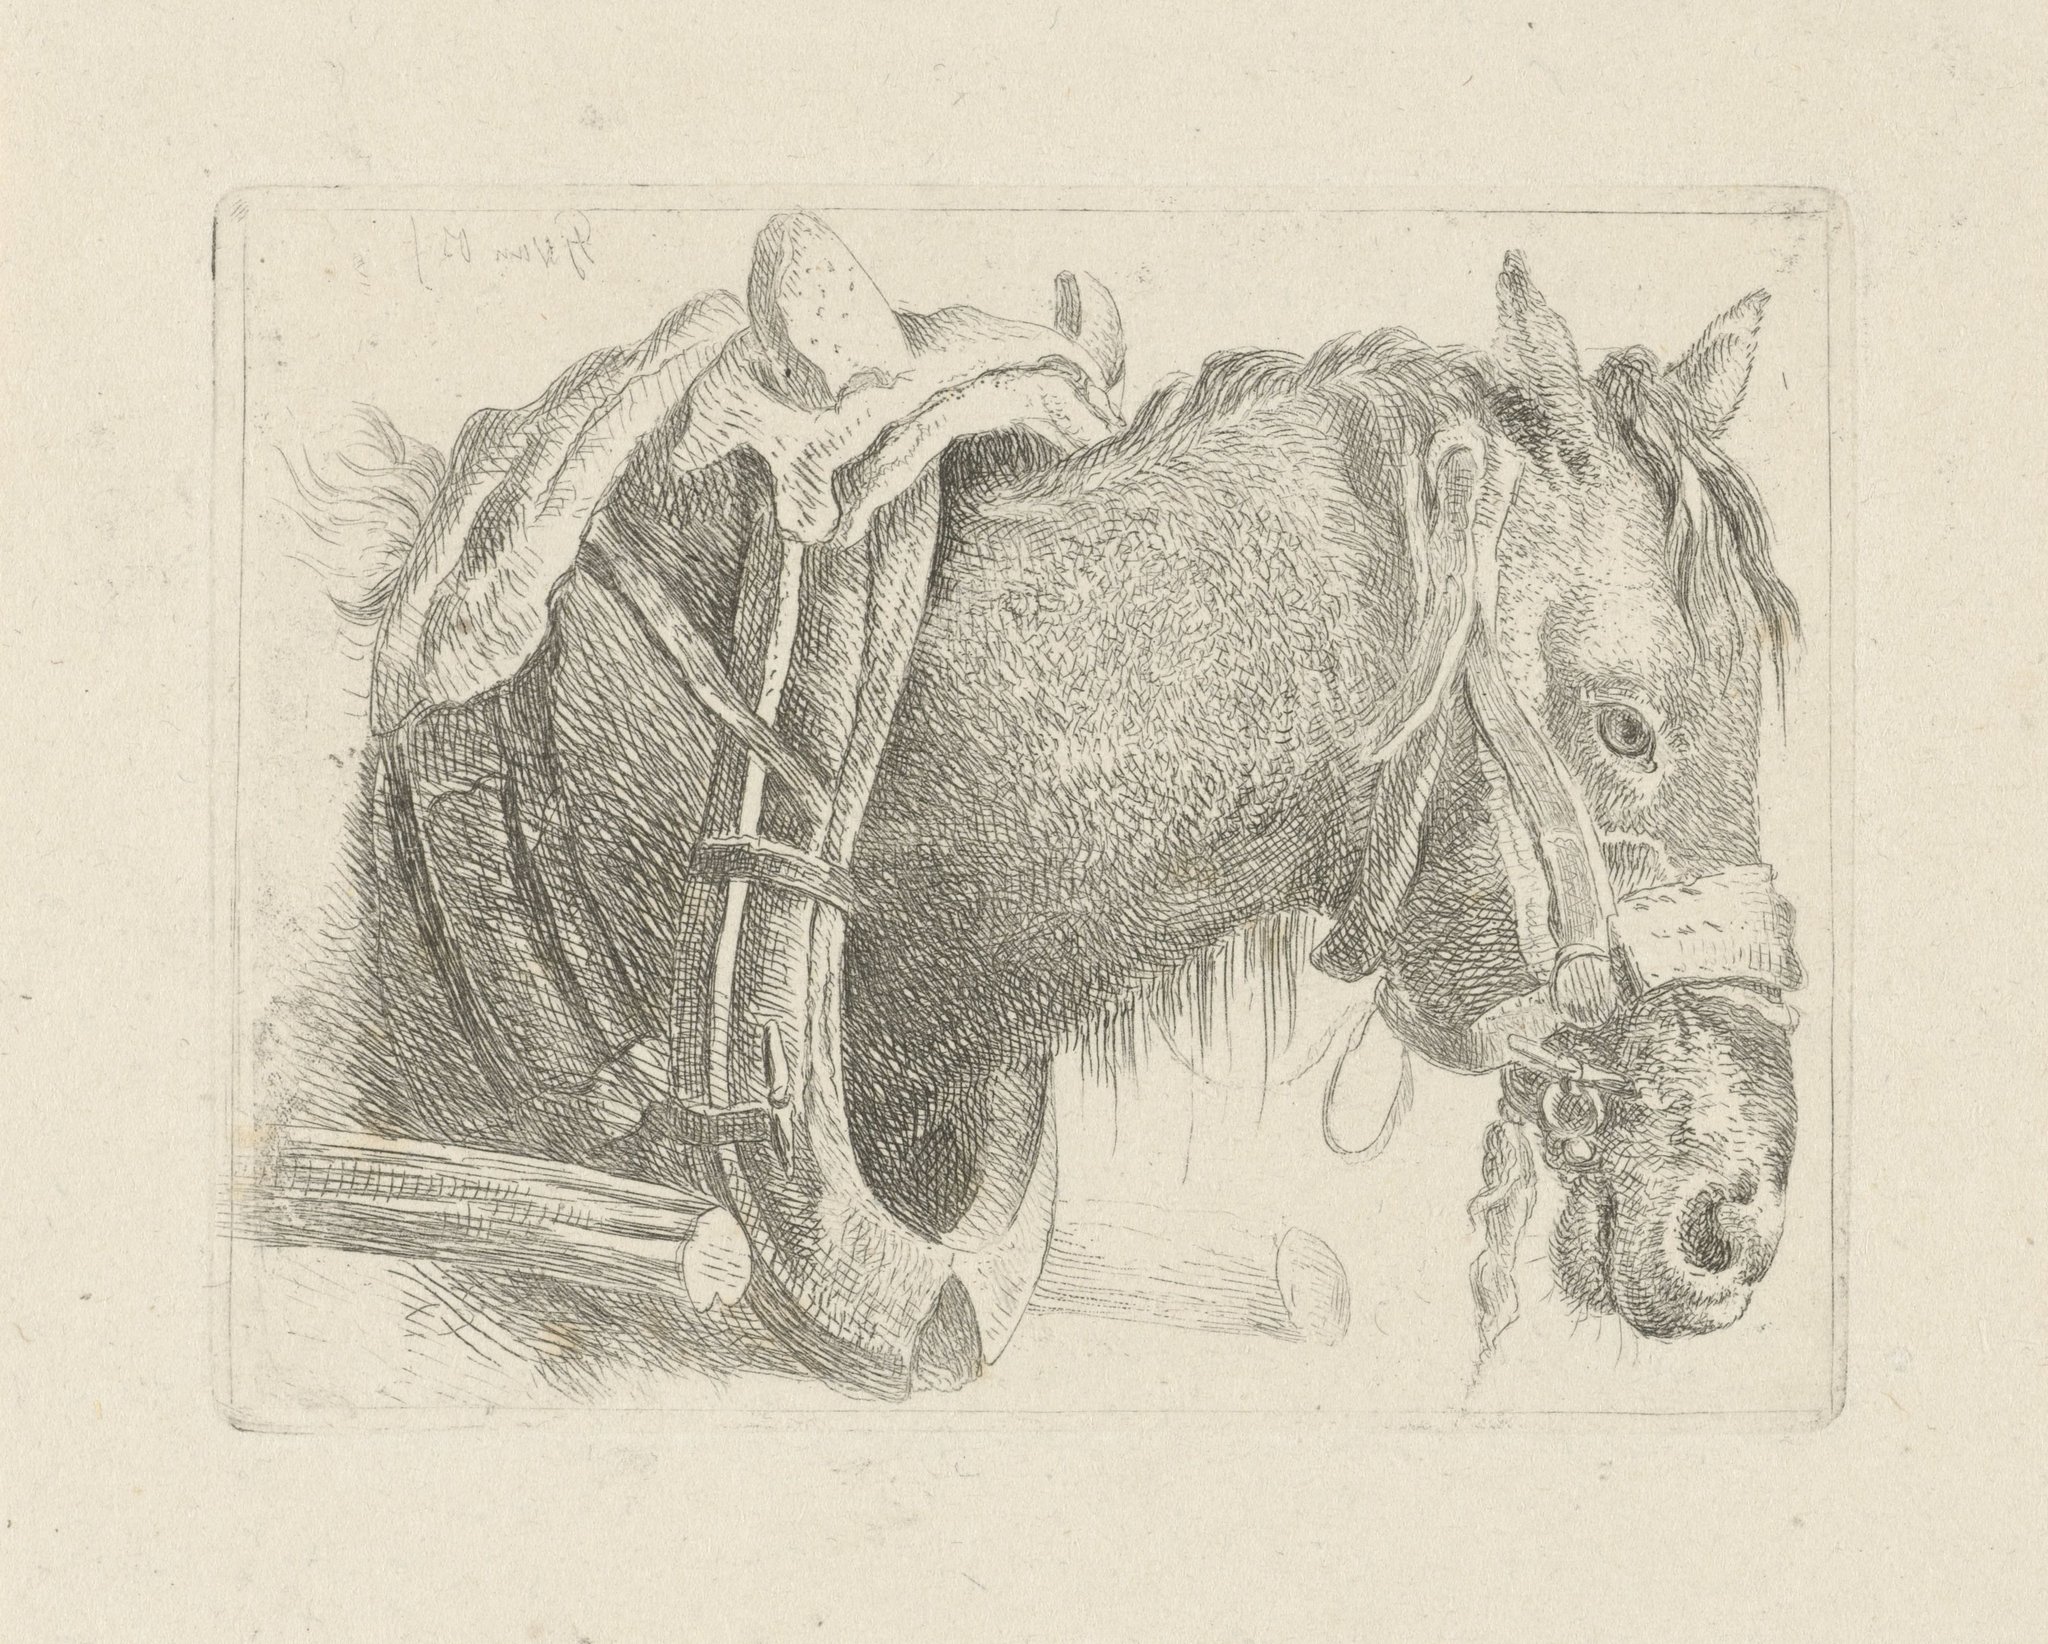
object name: print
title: Studie van een paardenkop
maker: pieter gerardus van os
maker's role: draughtsman, painter, print maker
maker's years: 1776-1839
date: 1791-1839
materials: paper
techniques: etching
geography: netherlands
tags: horse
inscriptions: collector's mark: Lugt 2228